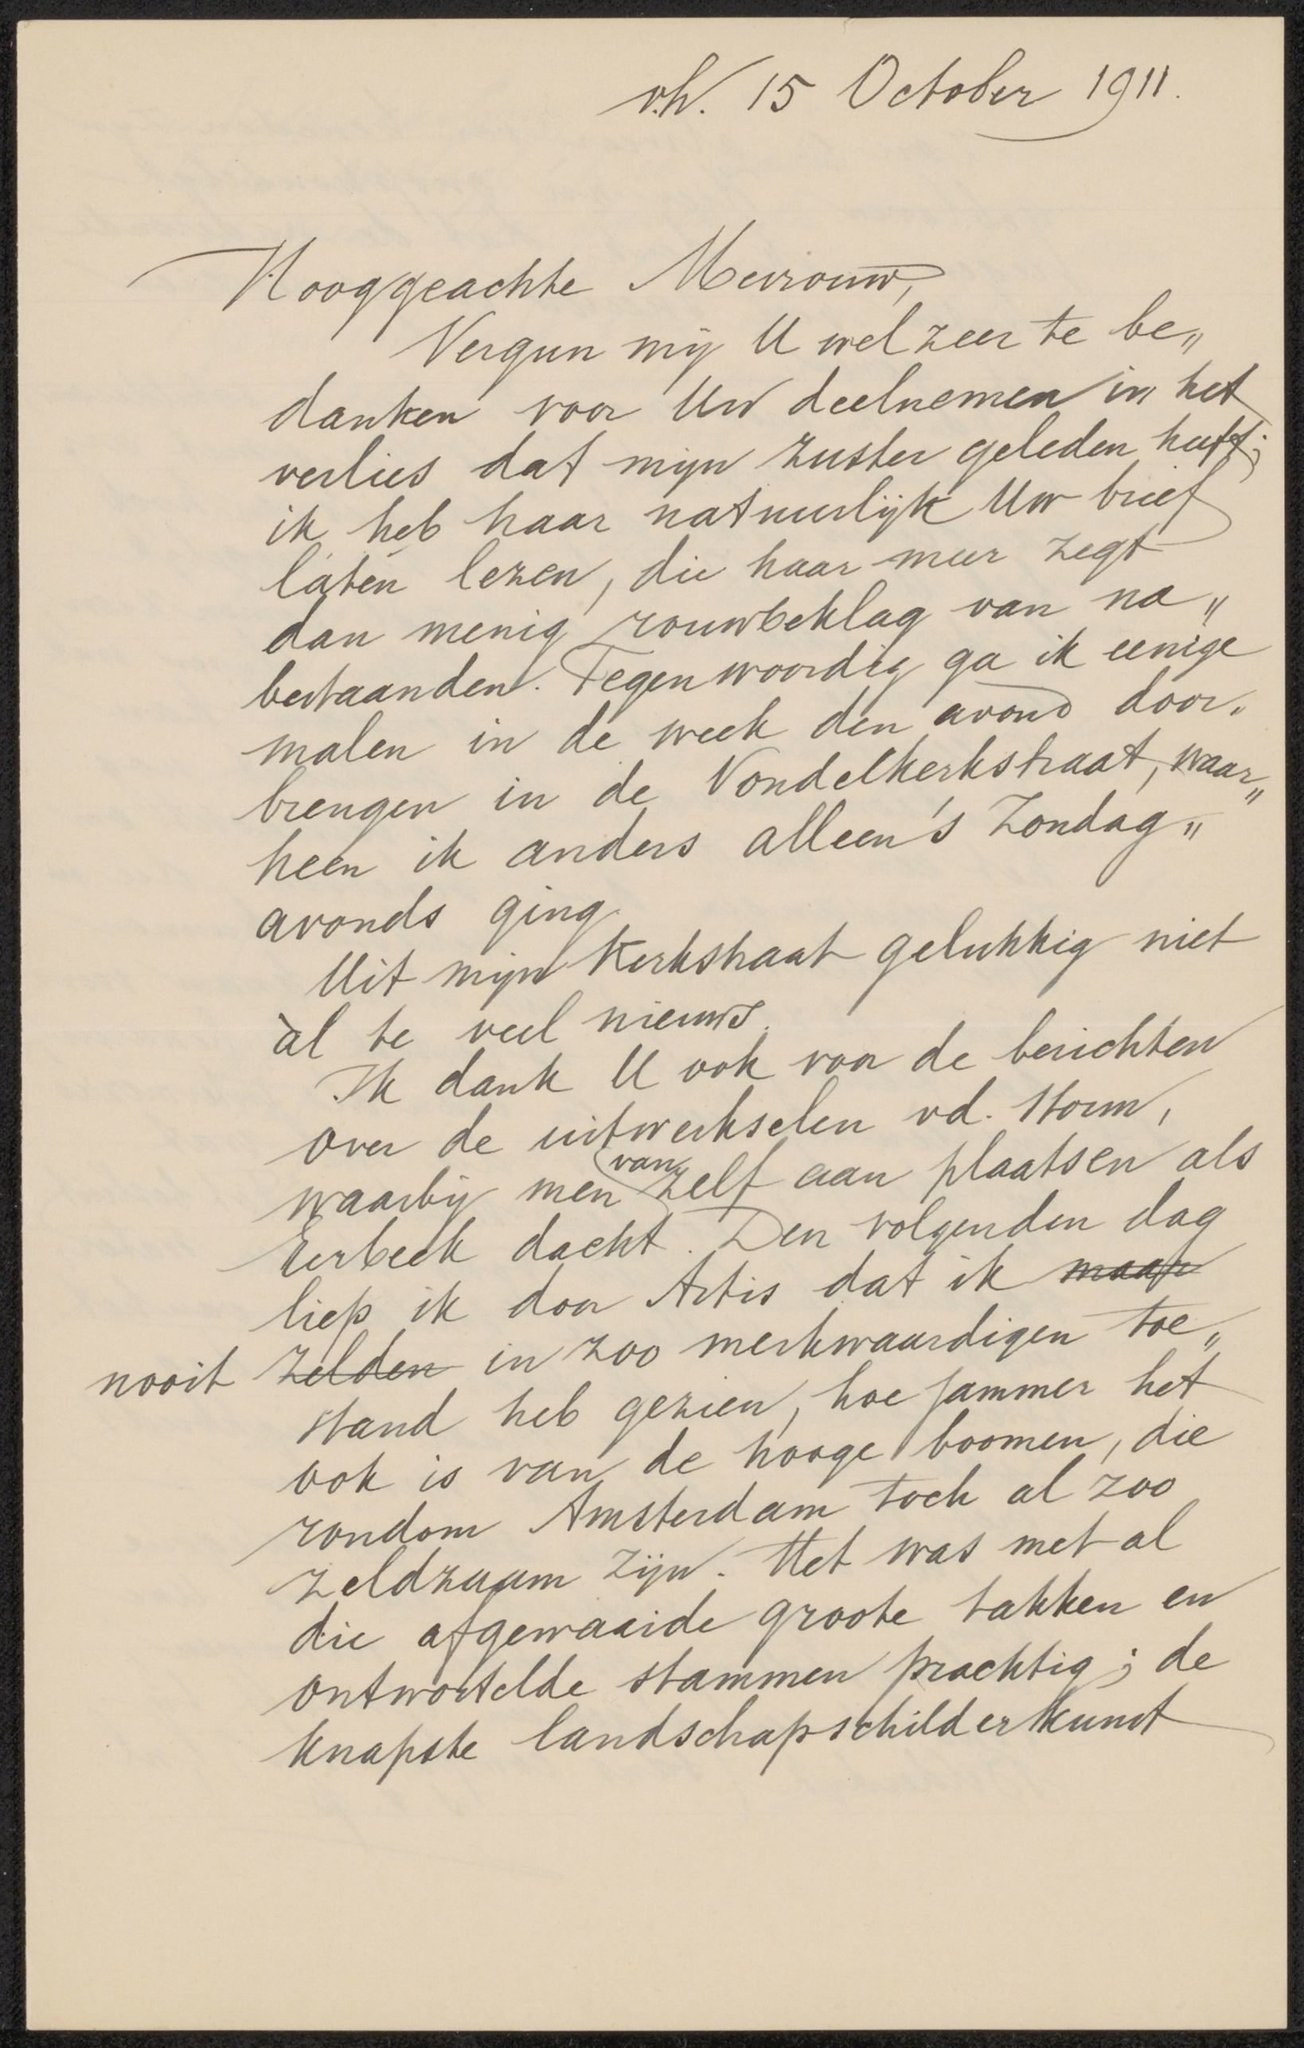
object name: letter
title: Brief aan Anne Antoinette Weber-Van Bosse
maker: august allebé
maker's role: draughtsman, print maker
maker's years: 1838-1927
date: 1911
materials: ink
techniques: pen, writing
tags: amsterdam, anne antoinette weber-van bosse, drawing, painting (including book-illumination, miniature-painting)